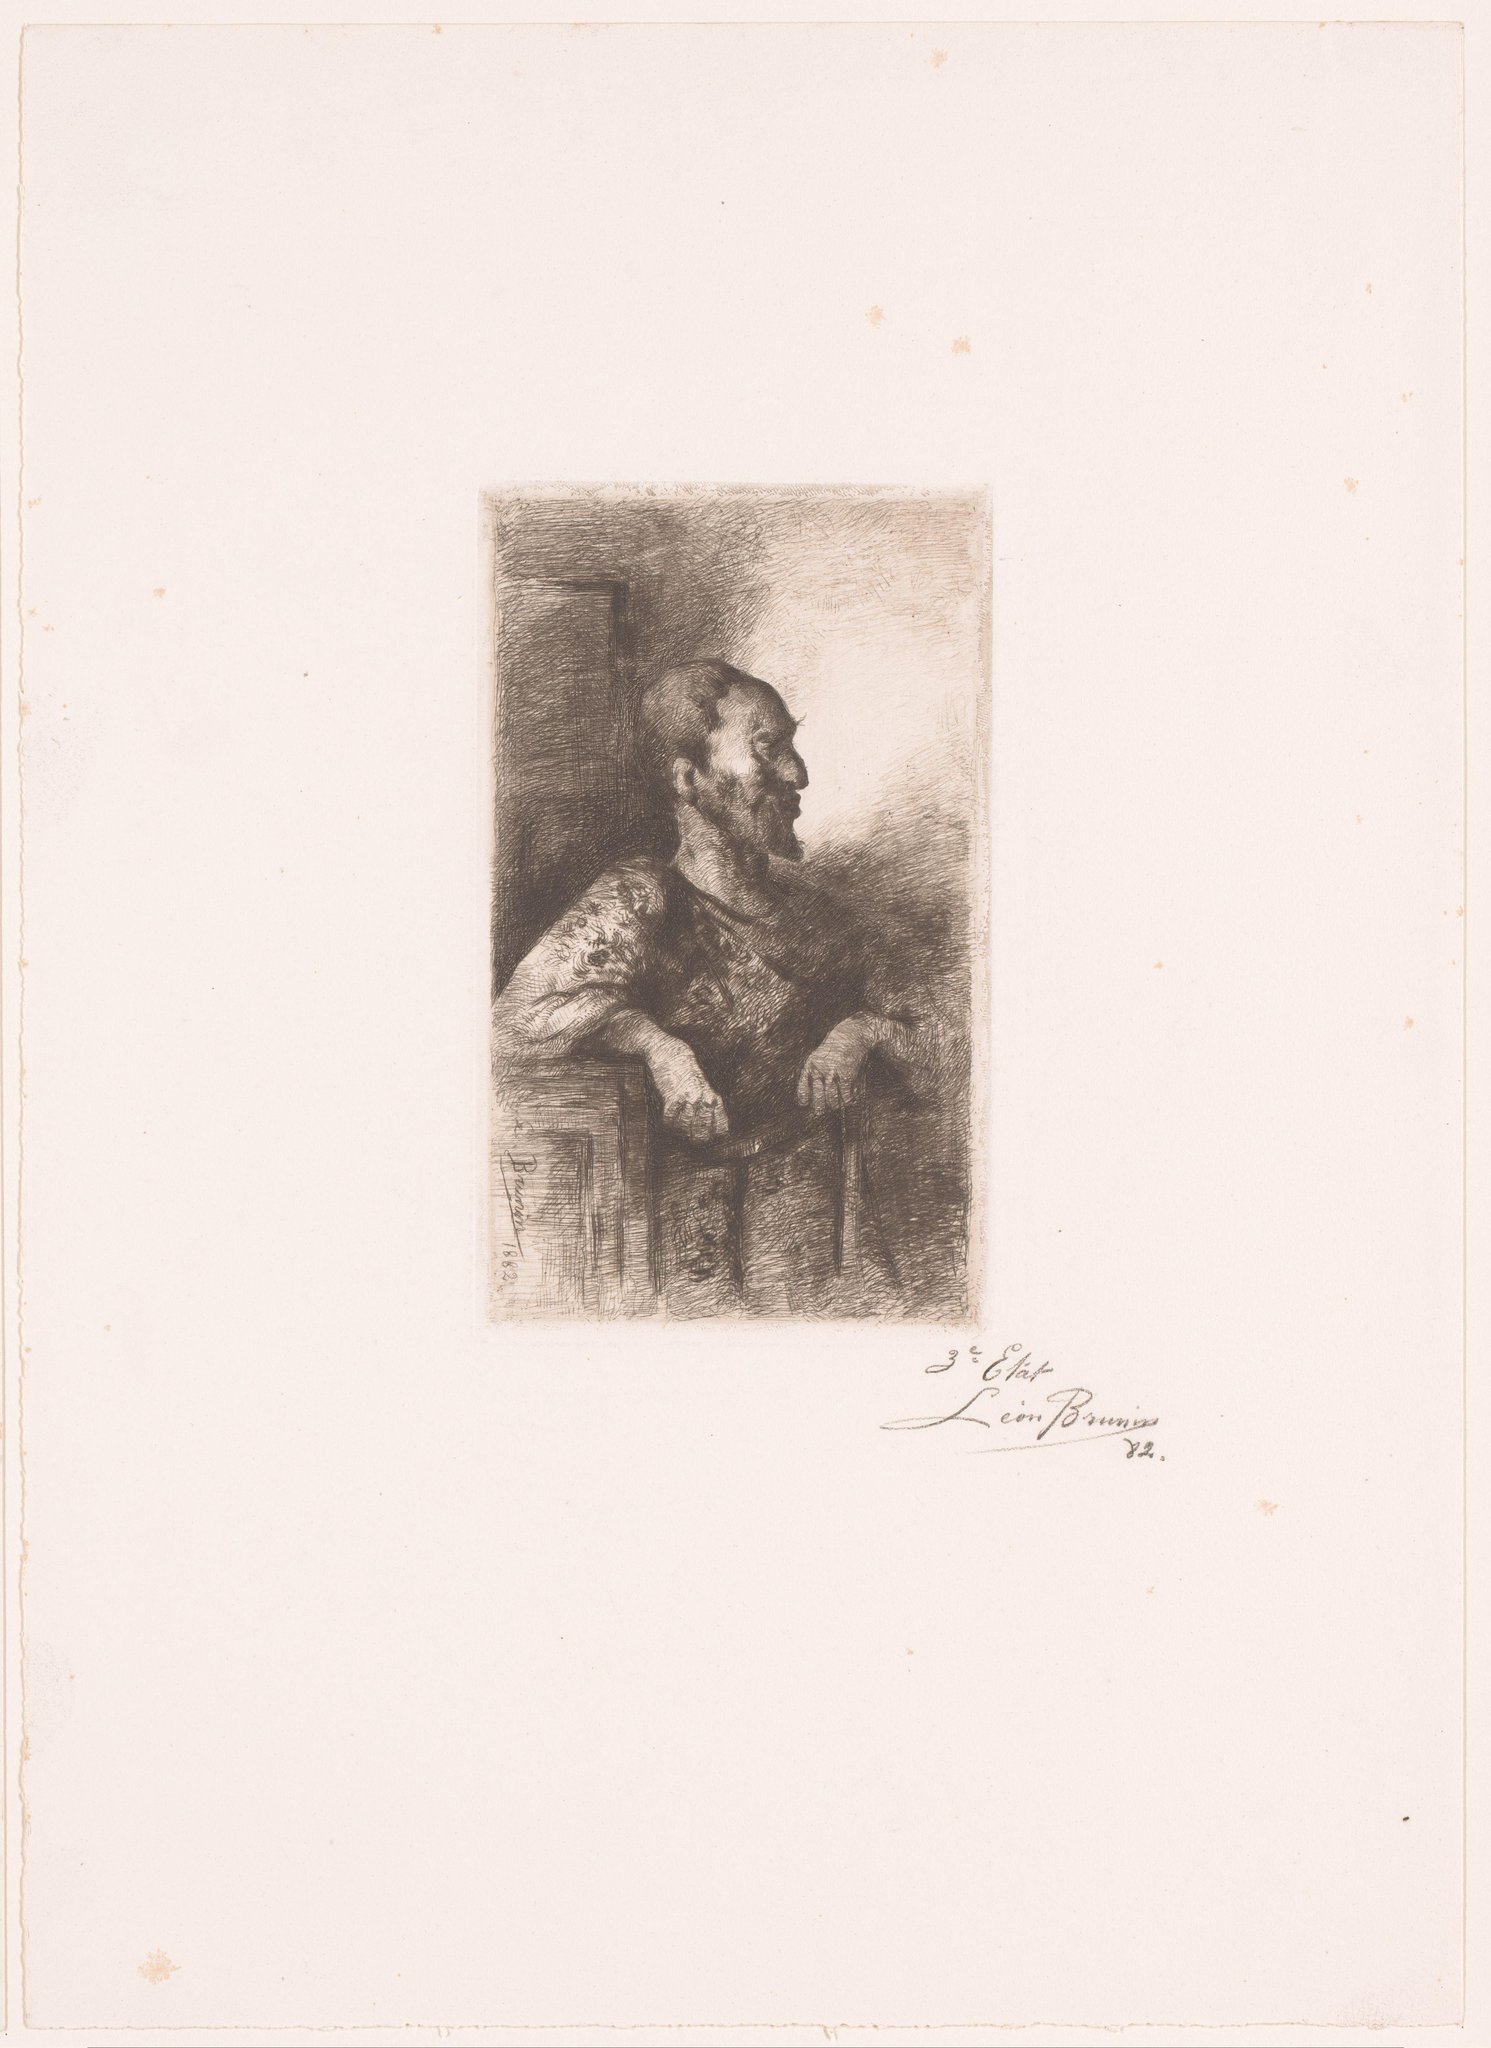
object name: print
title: Portret van een onbekende bebaarde man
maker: léon brunin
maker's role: print maker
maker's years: 1861-1949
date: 1882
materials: paper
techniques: etching, intaglio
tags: anonymous historical person portrayed alone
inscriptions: collector's mark: Lugt 2228, annotation: ‘3e Etat’